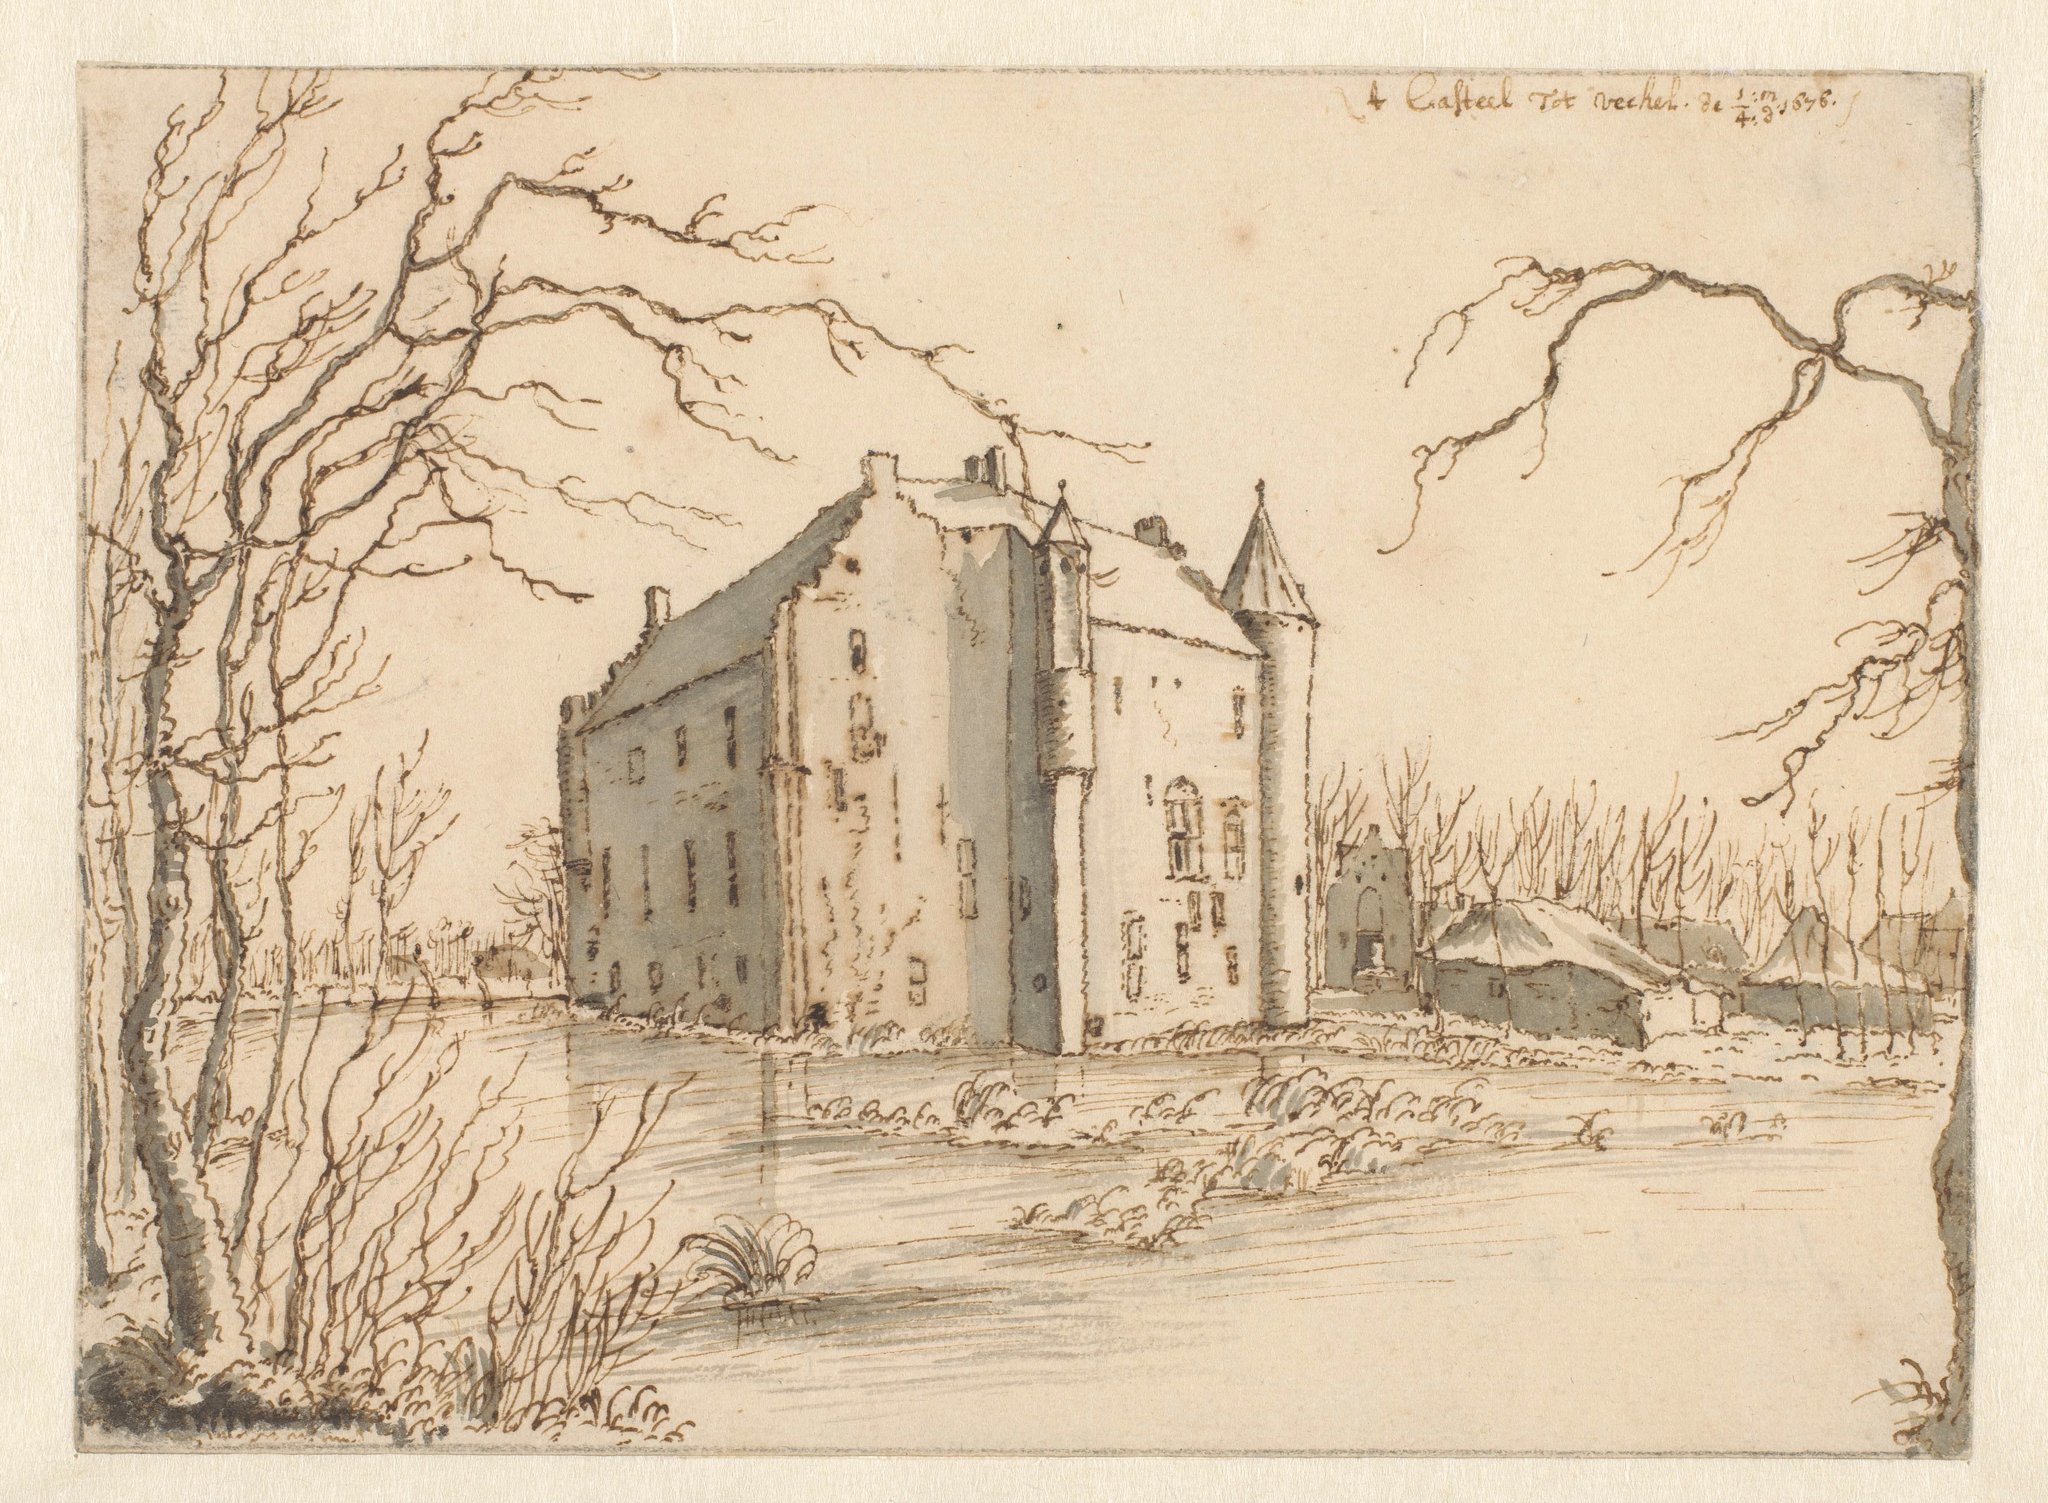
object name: drawing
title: View of Kasteel Frisselstein, Veghel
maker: valentijn klotz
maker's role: draughtsman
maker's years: 1646-1721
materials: ink, paper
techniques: brush, pen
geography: veghel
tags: castle